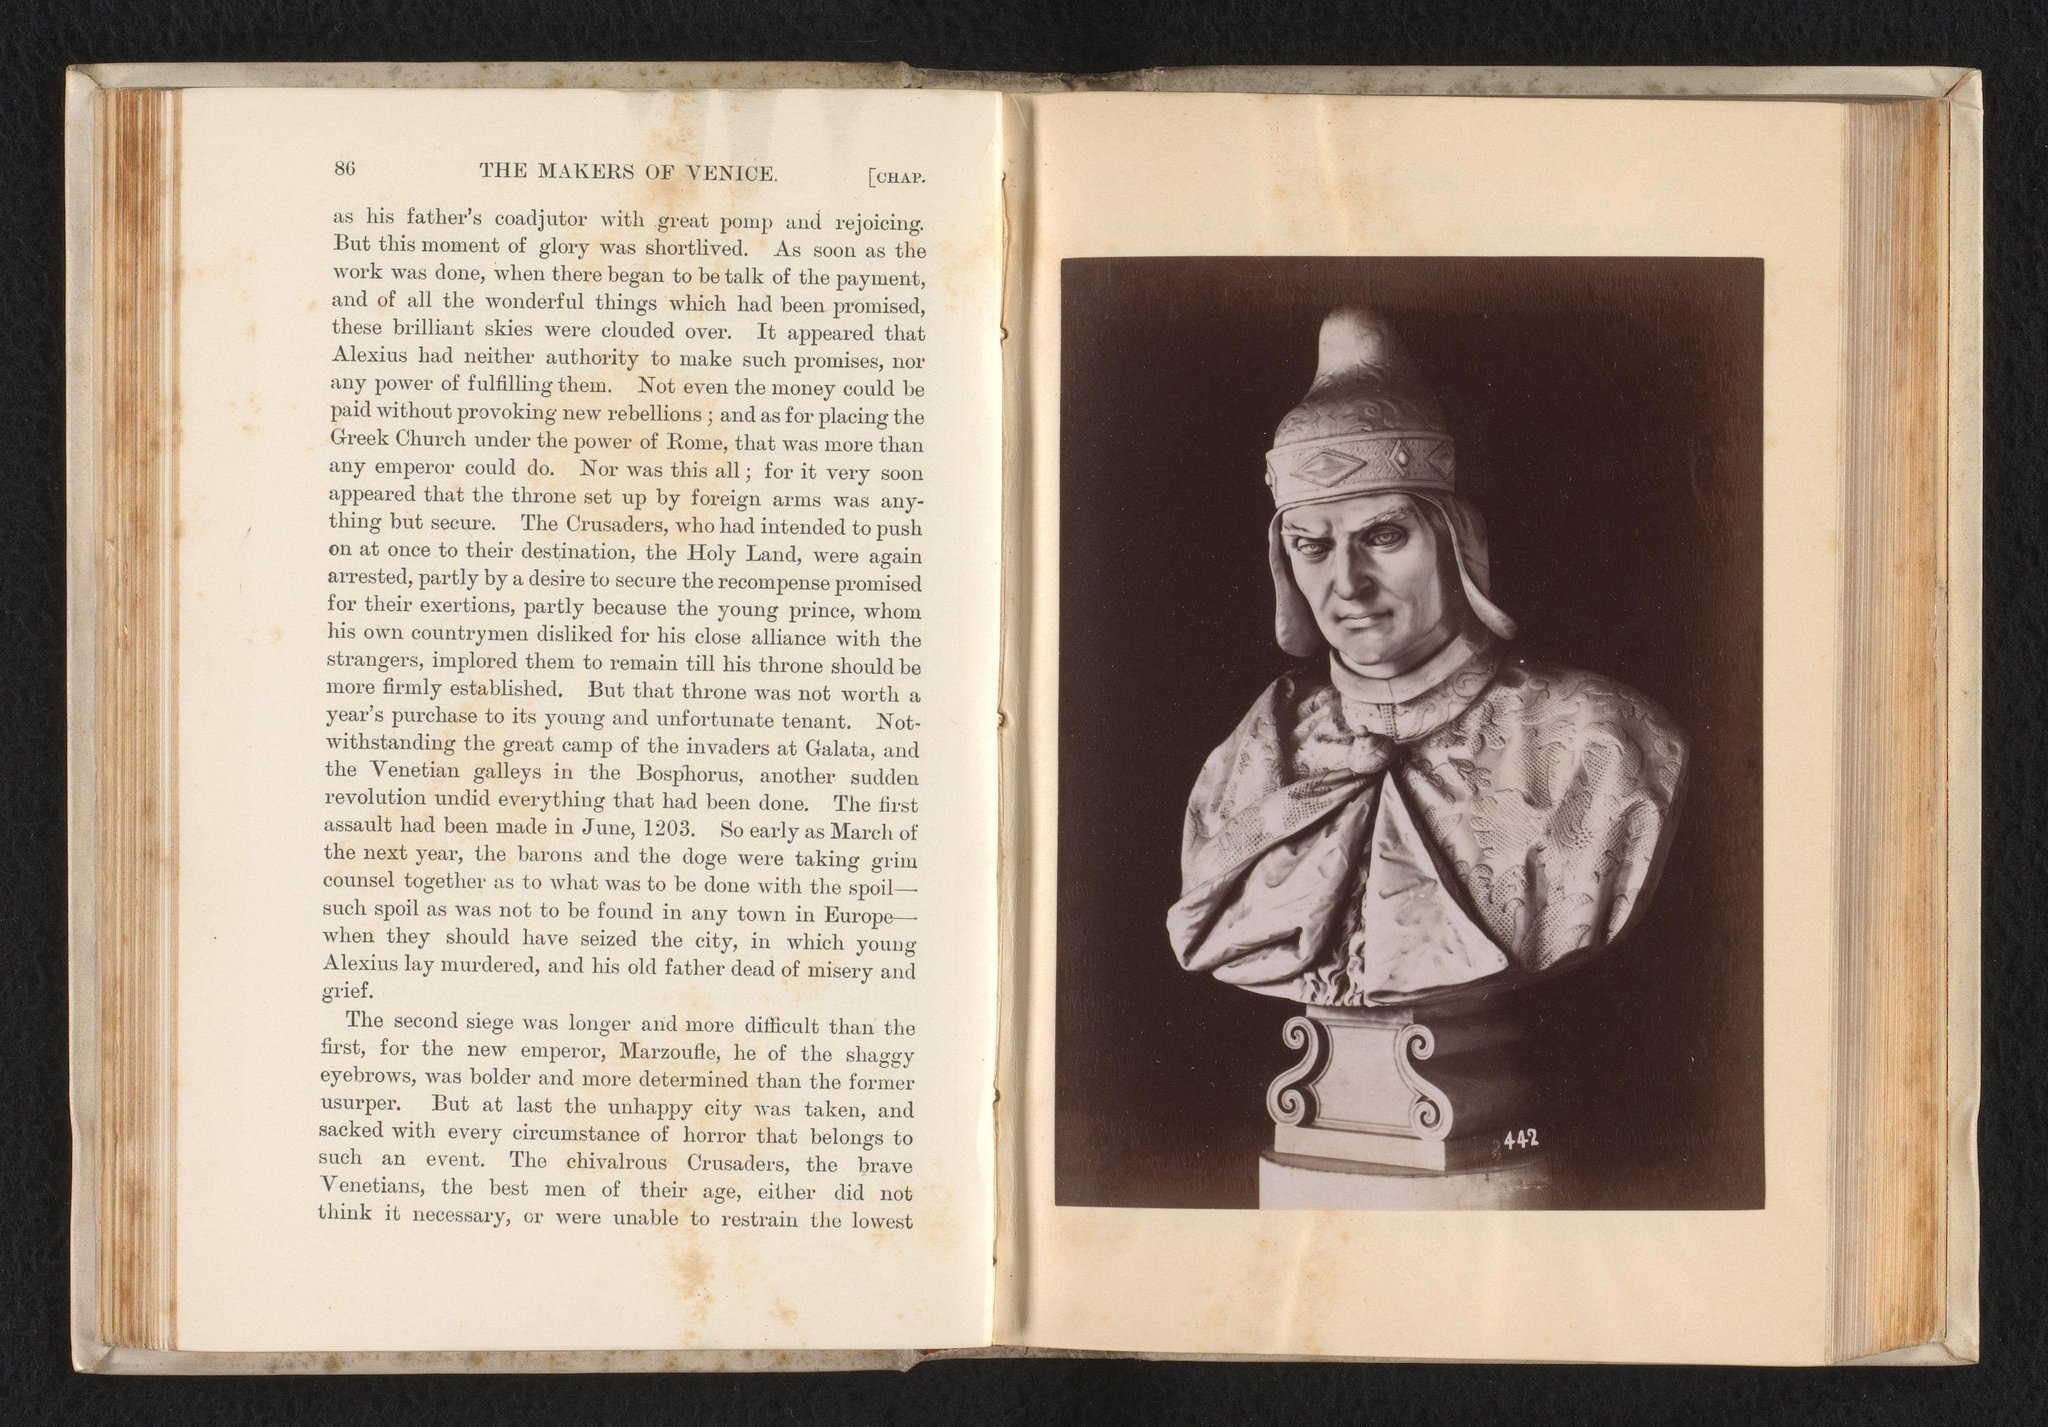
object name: photograph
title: Buste van een man, vermoedelijk keizer Alexios V Doukas Mourtzouphlos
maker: Anonymous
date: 1888-1893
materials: paper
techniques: albumen print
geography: venice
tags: historical persons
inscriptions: number: ‘442’